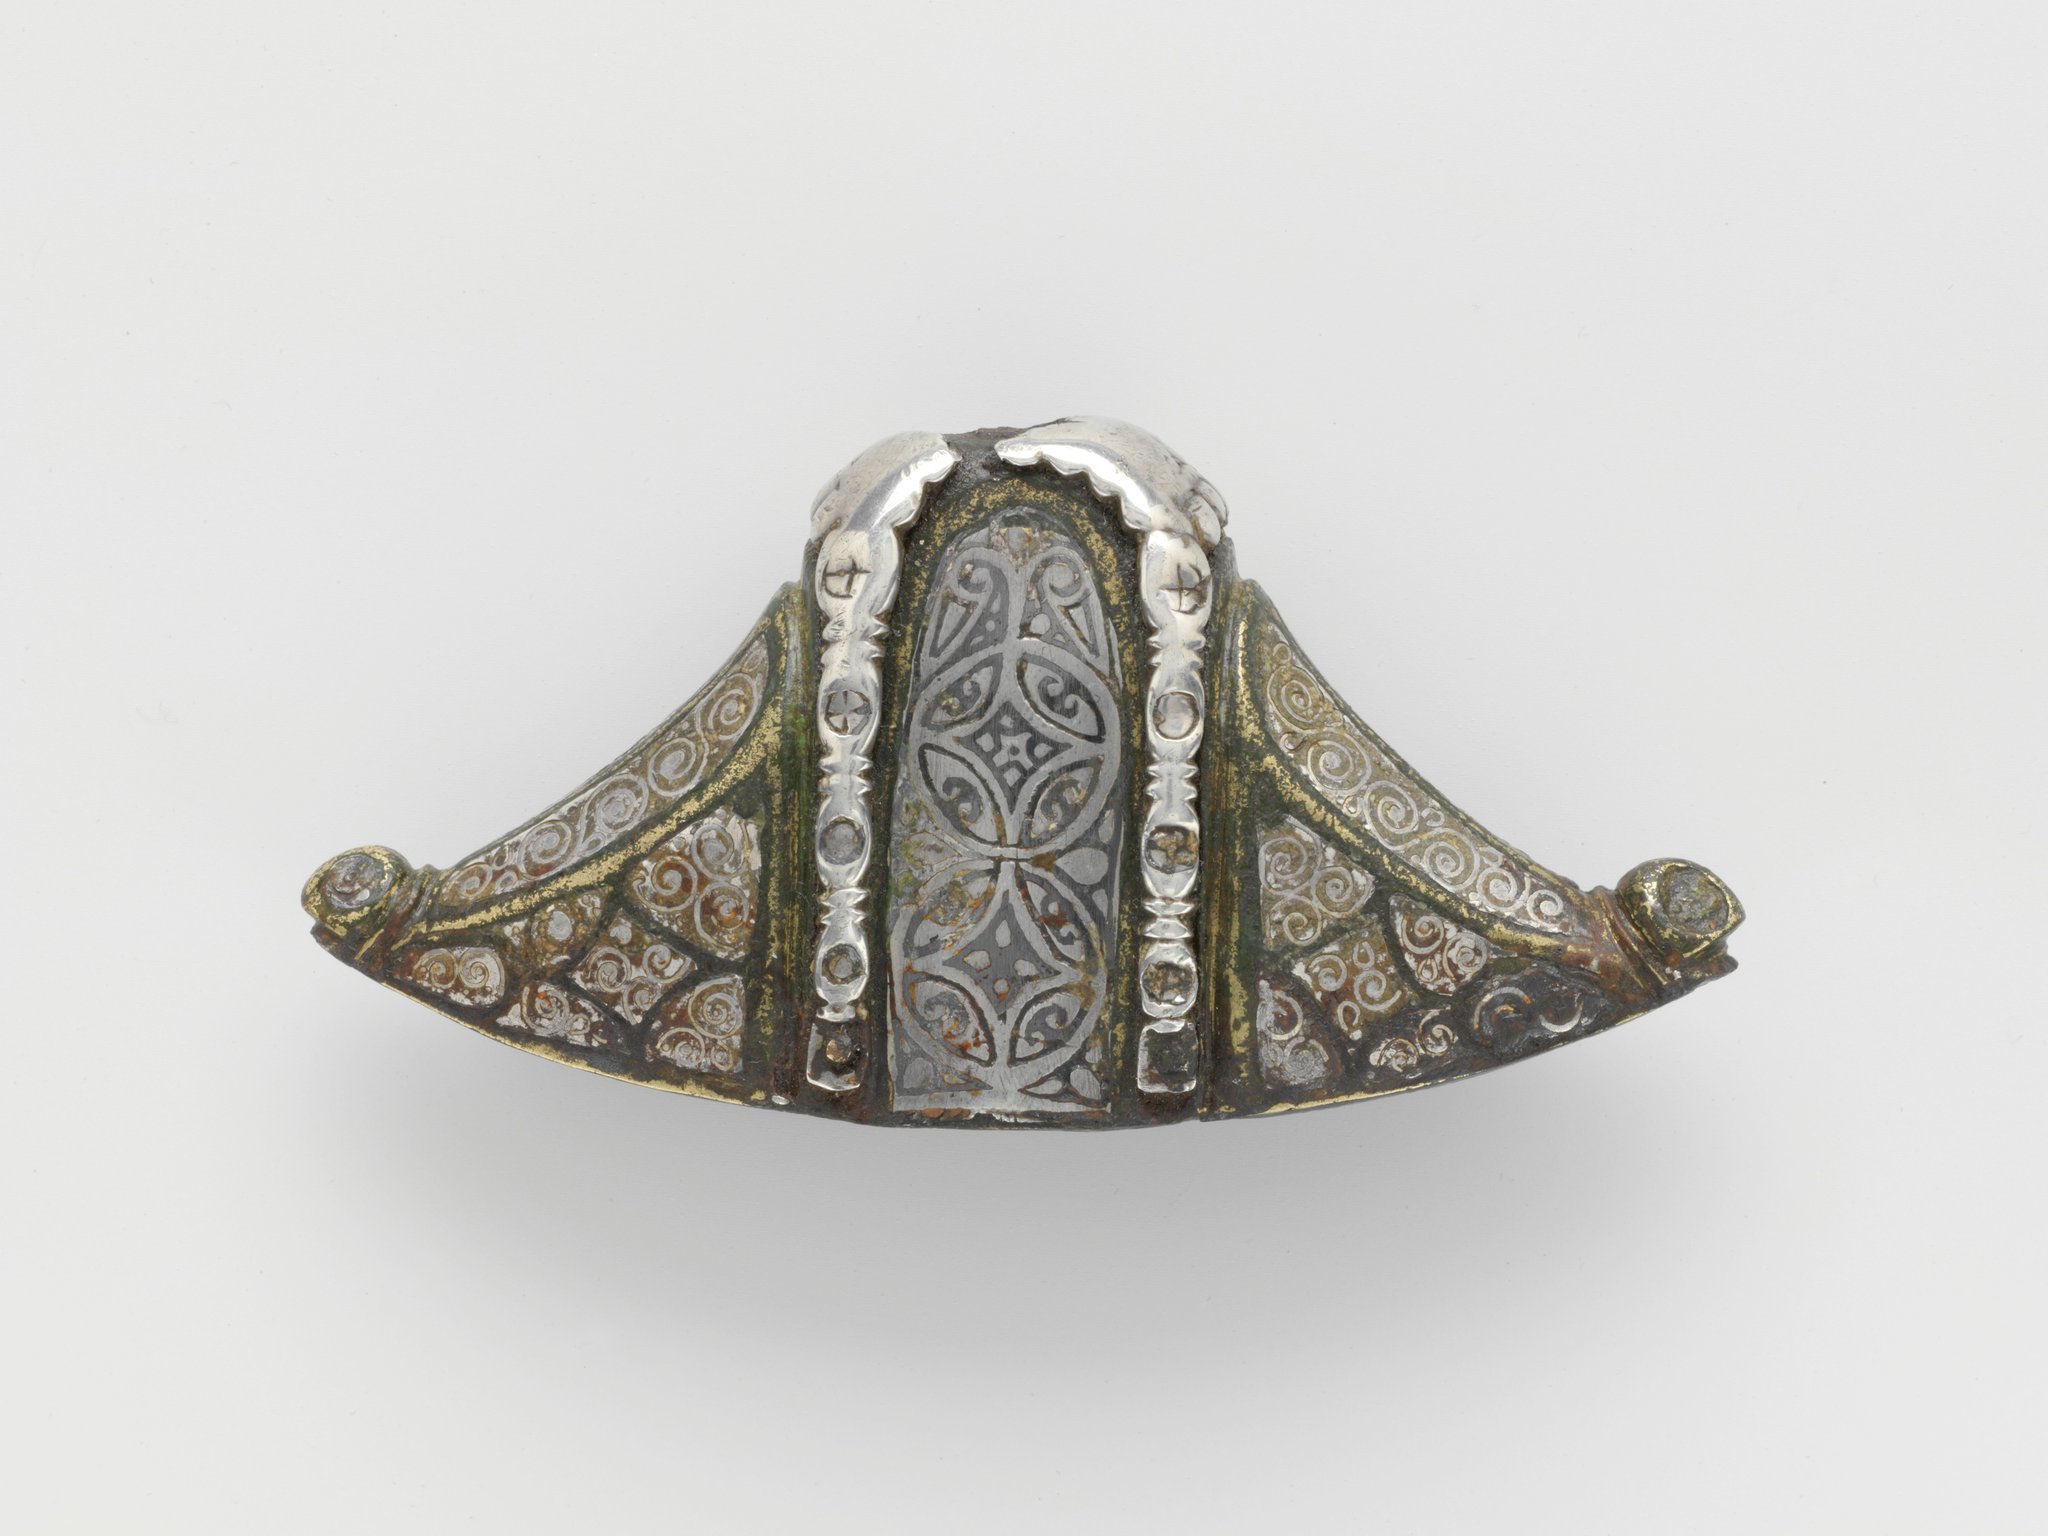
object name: pommel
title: Sword Pommel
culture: anglo-saxon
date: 867-900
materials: copper alloy, iron, niello, silver, metal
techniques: inlay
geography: england